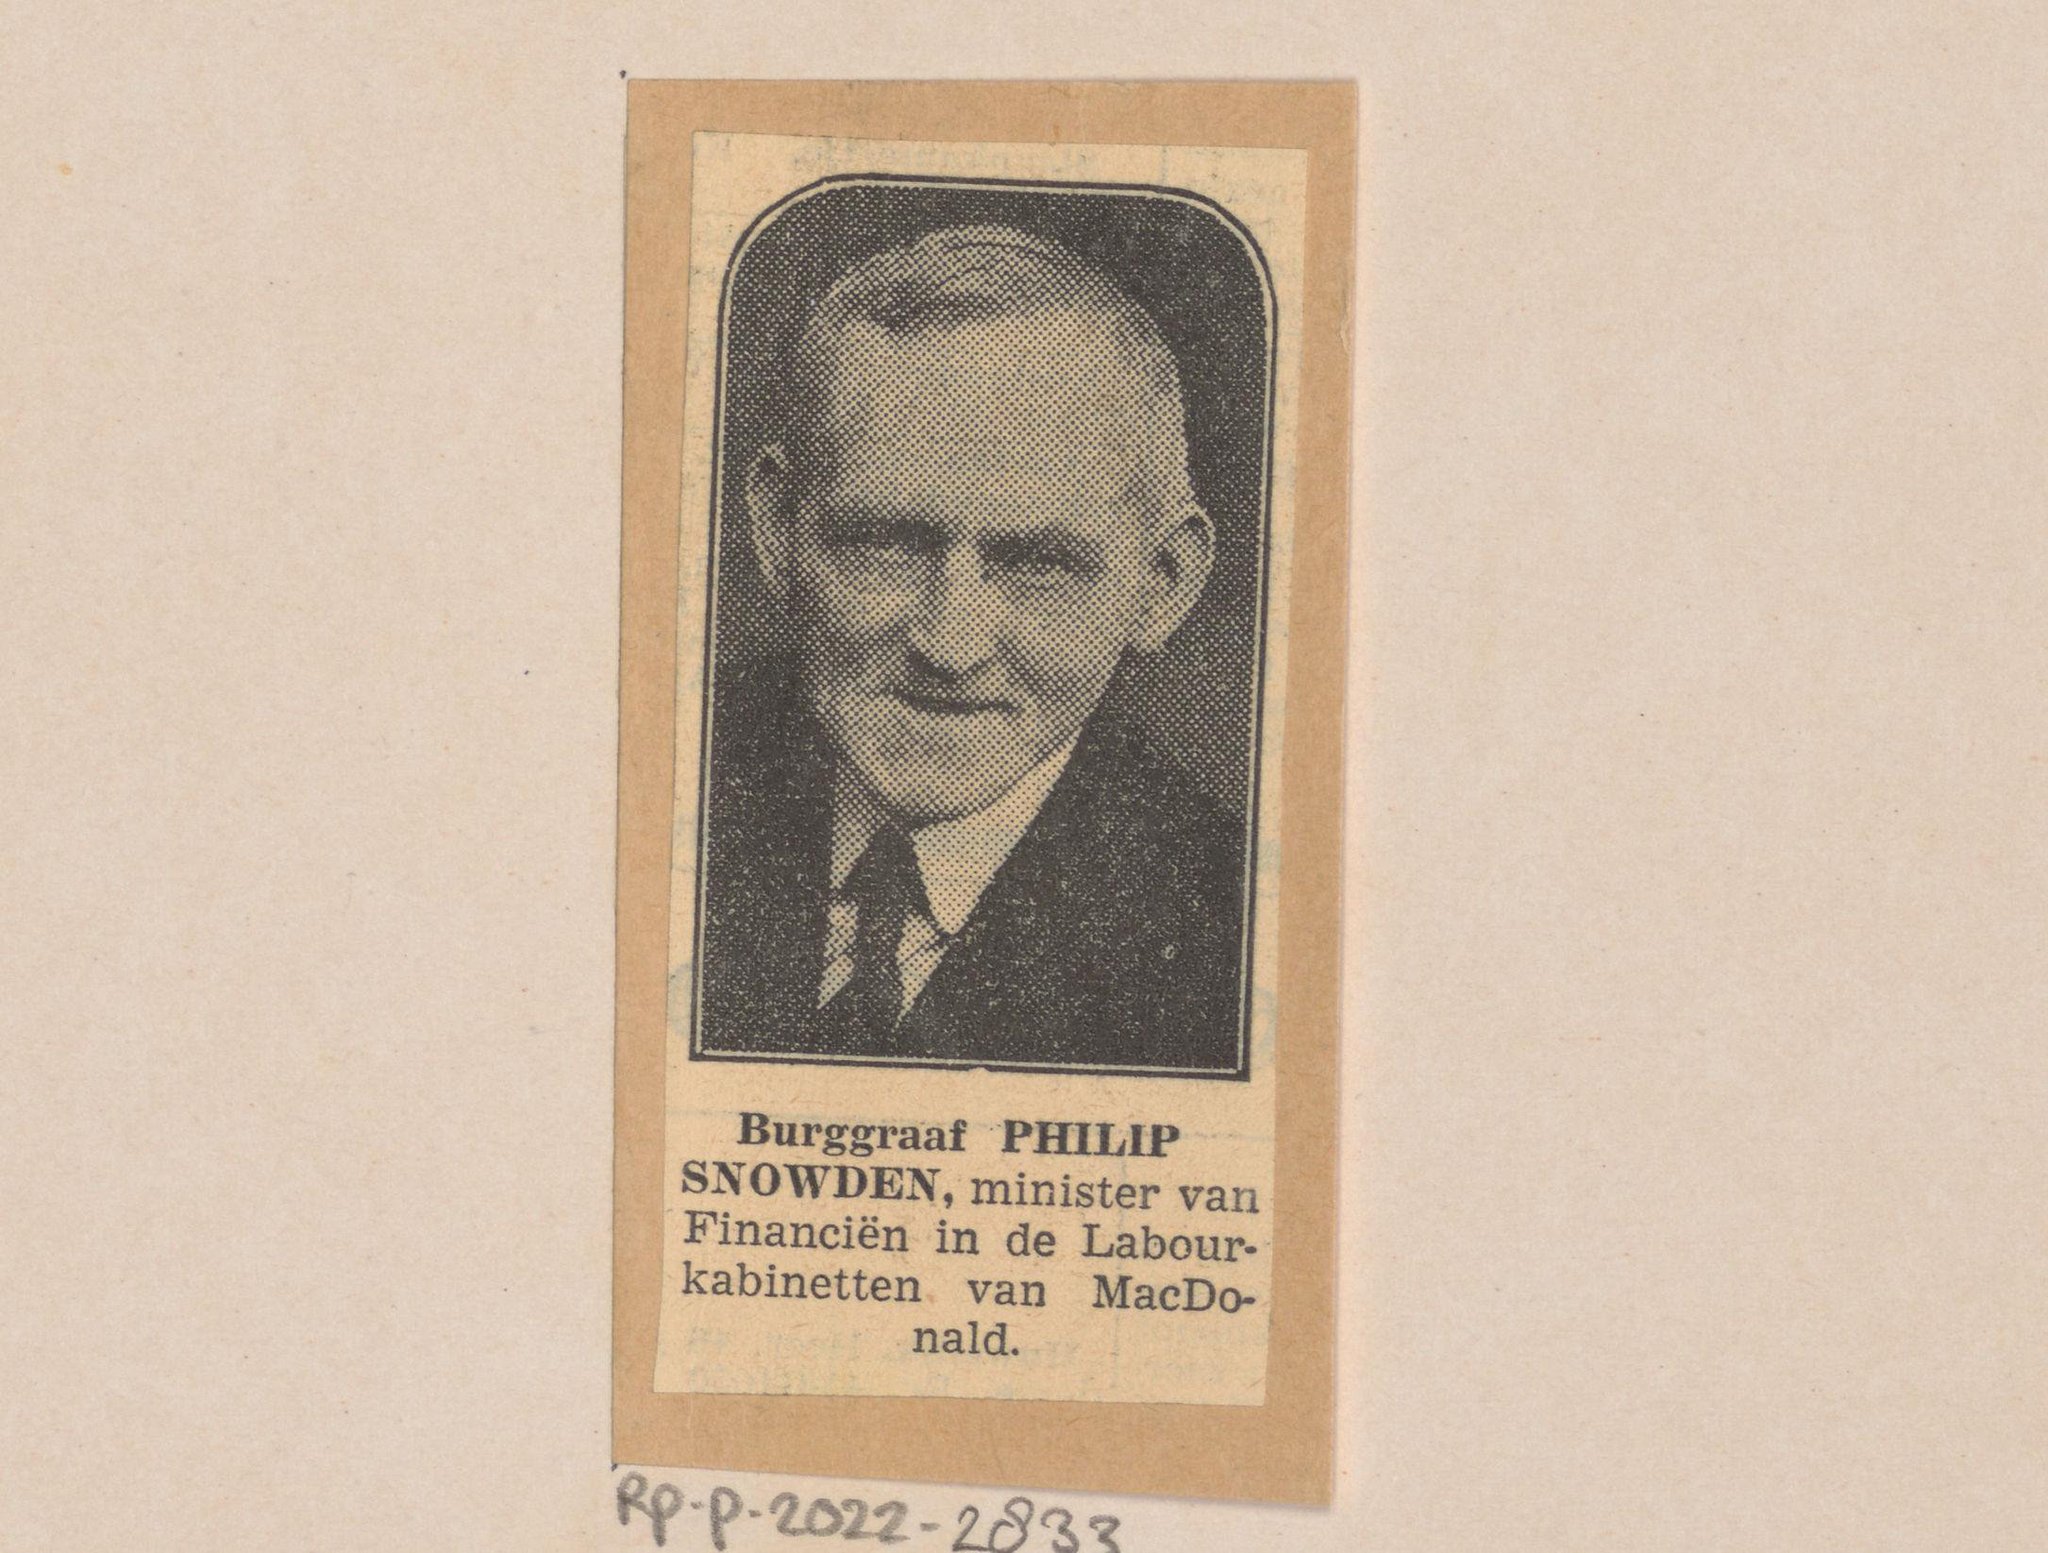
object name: photomechanical print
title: Portret van Philip Snowden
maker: Anonymous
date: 1924-1970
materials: paper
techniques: snipping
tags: politician, historical persons, politician, e.g. party leader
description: Fotomechanische afdruk uit een onbekende publicatie.